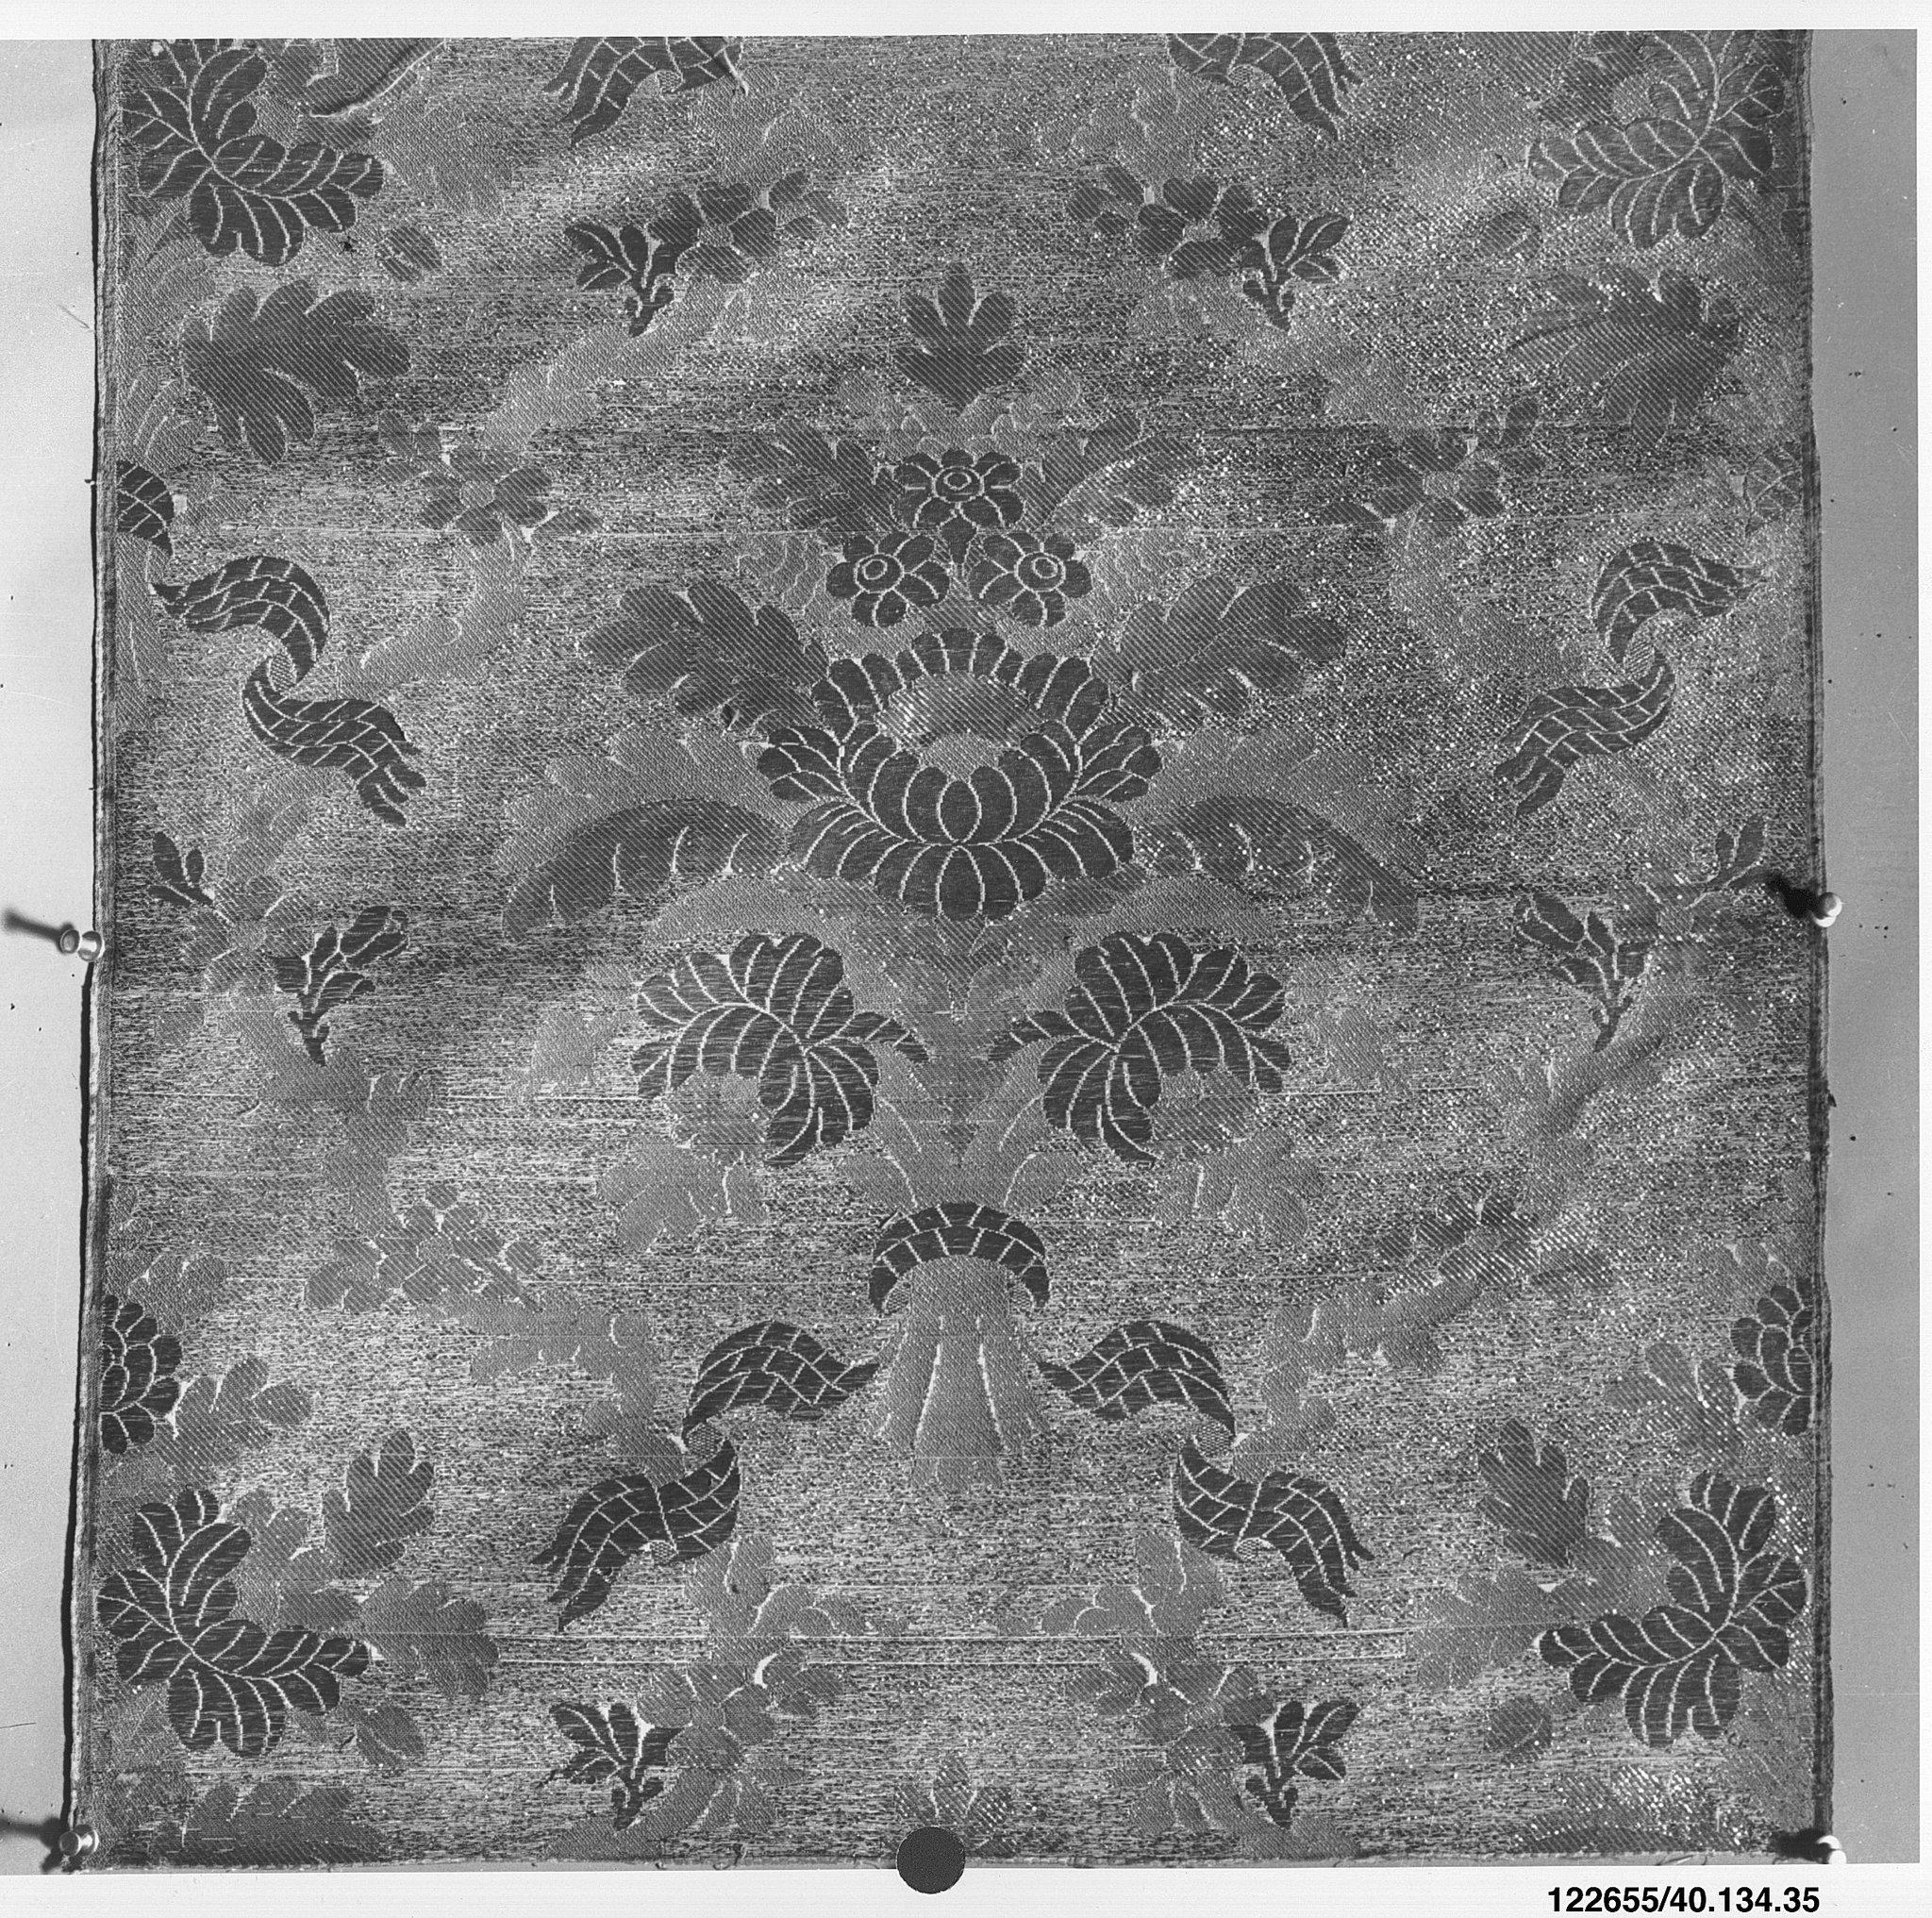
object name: piece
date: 1701-1900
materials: metal thread, silk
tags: flowers,leaves